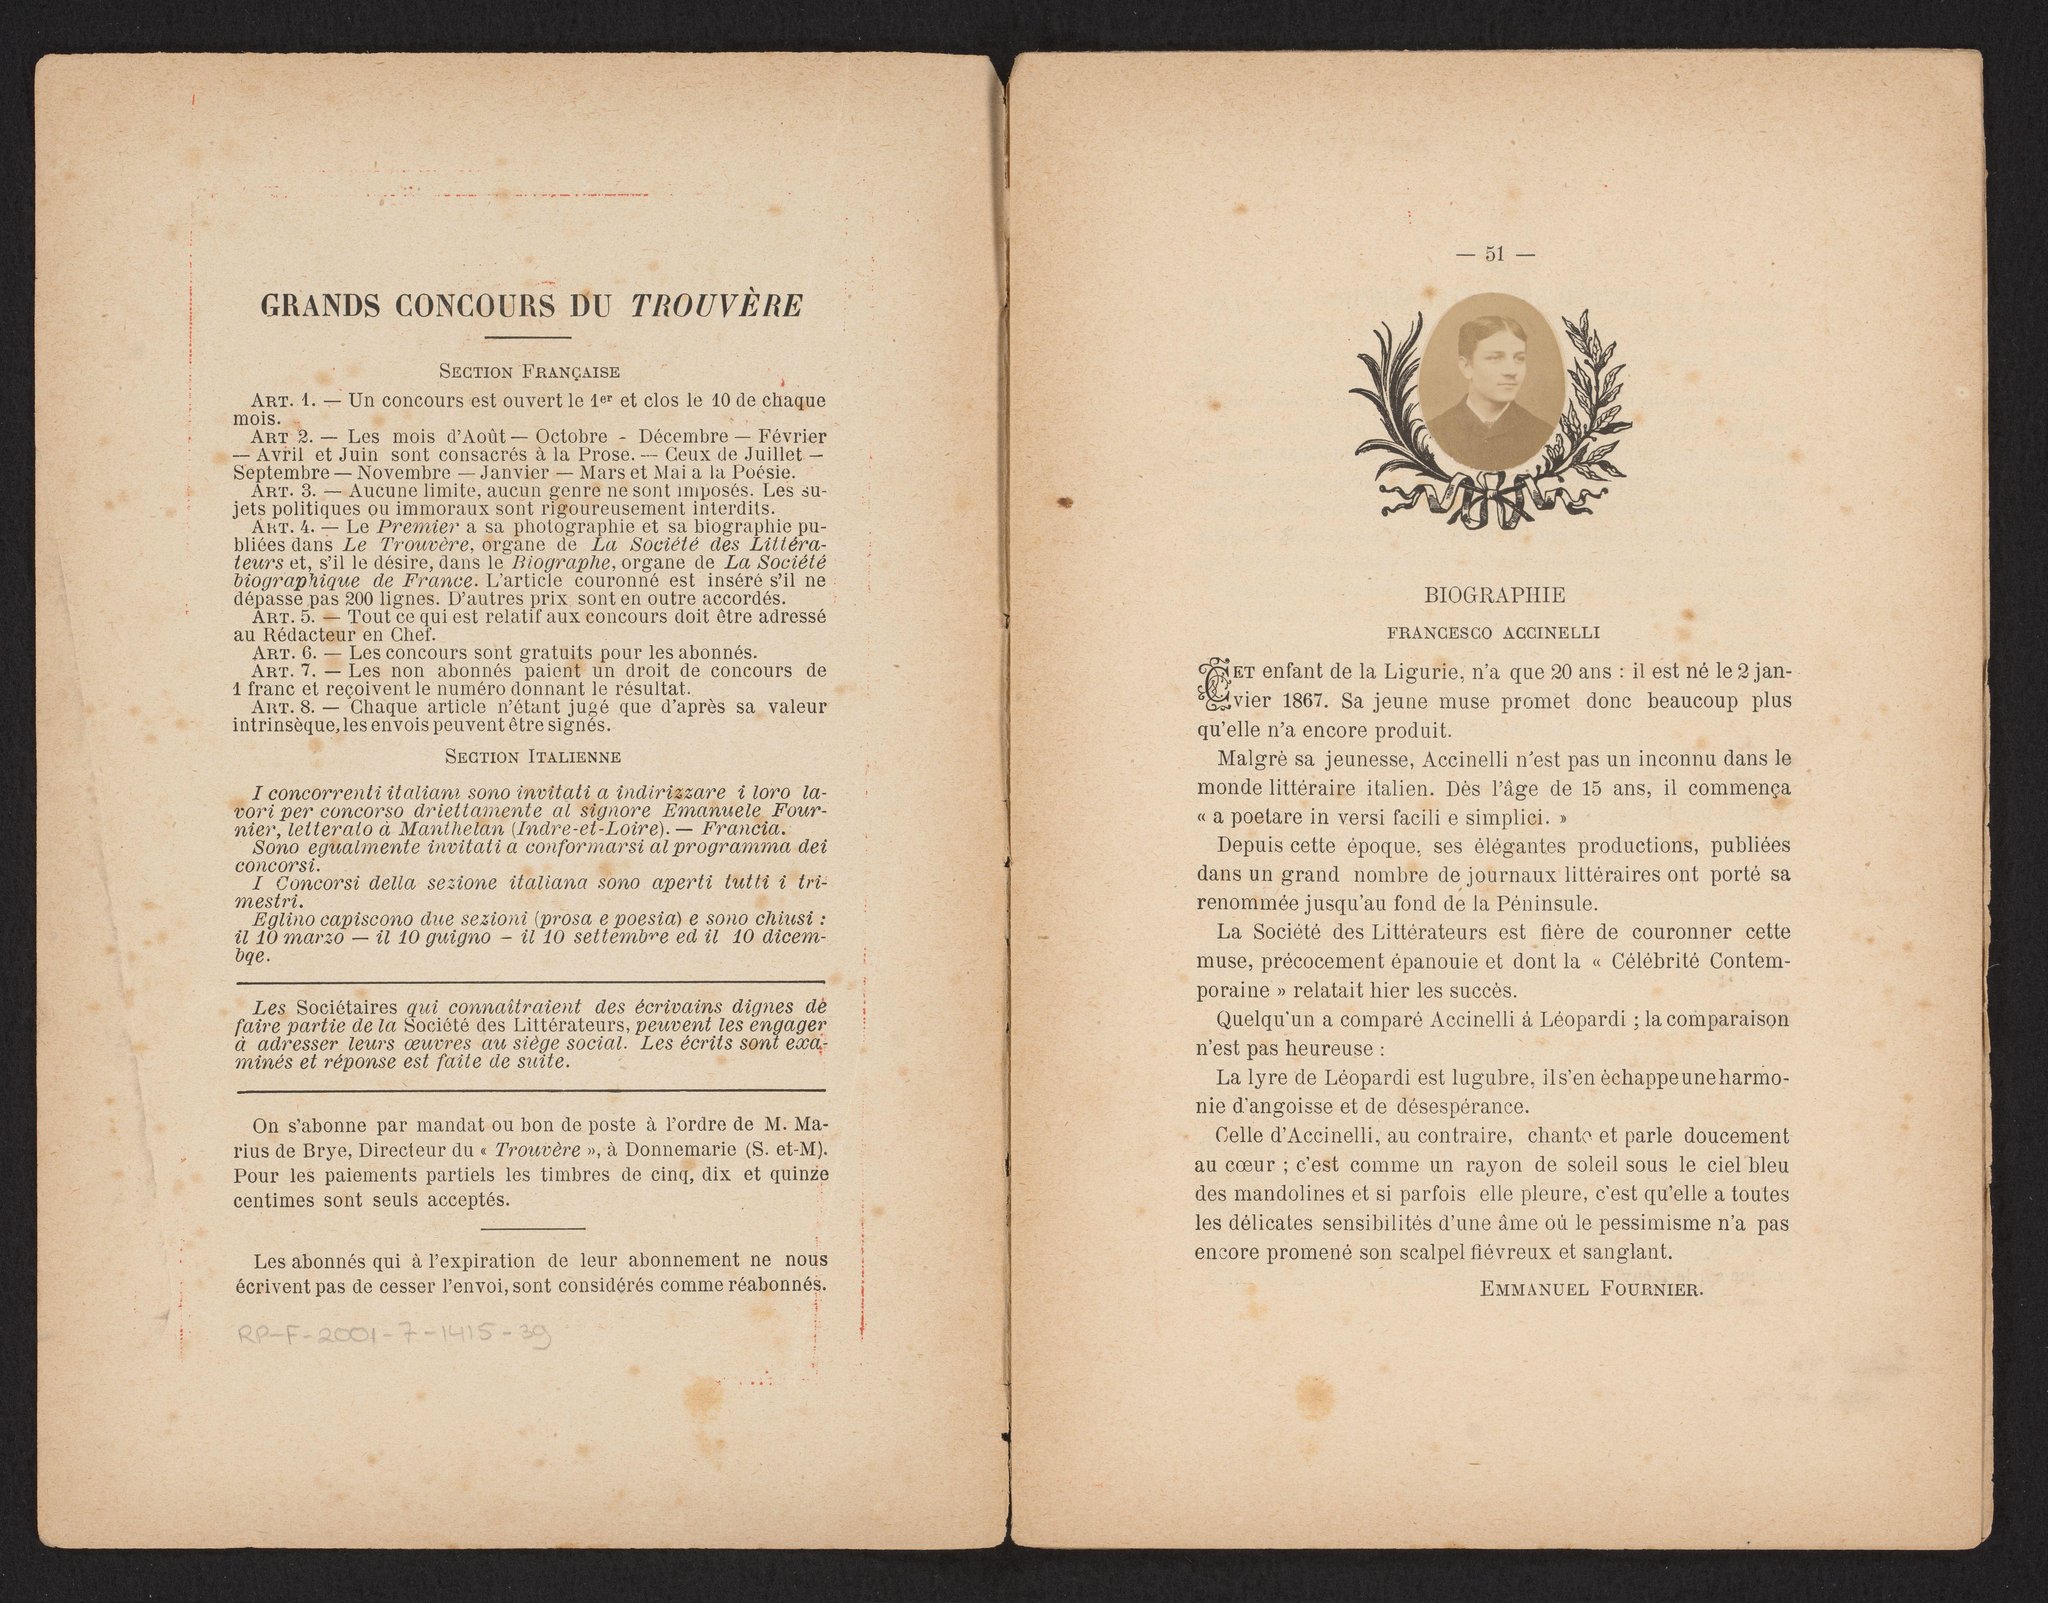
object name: page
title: Portret van Francesco Accinelli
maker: Anonymous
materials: photographic support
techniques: albumen print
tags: historical persons